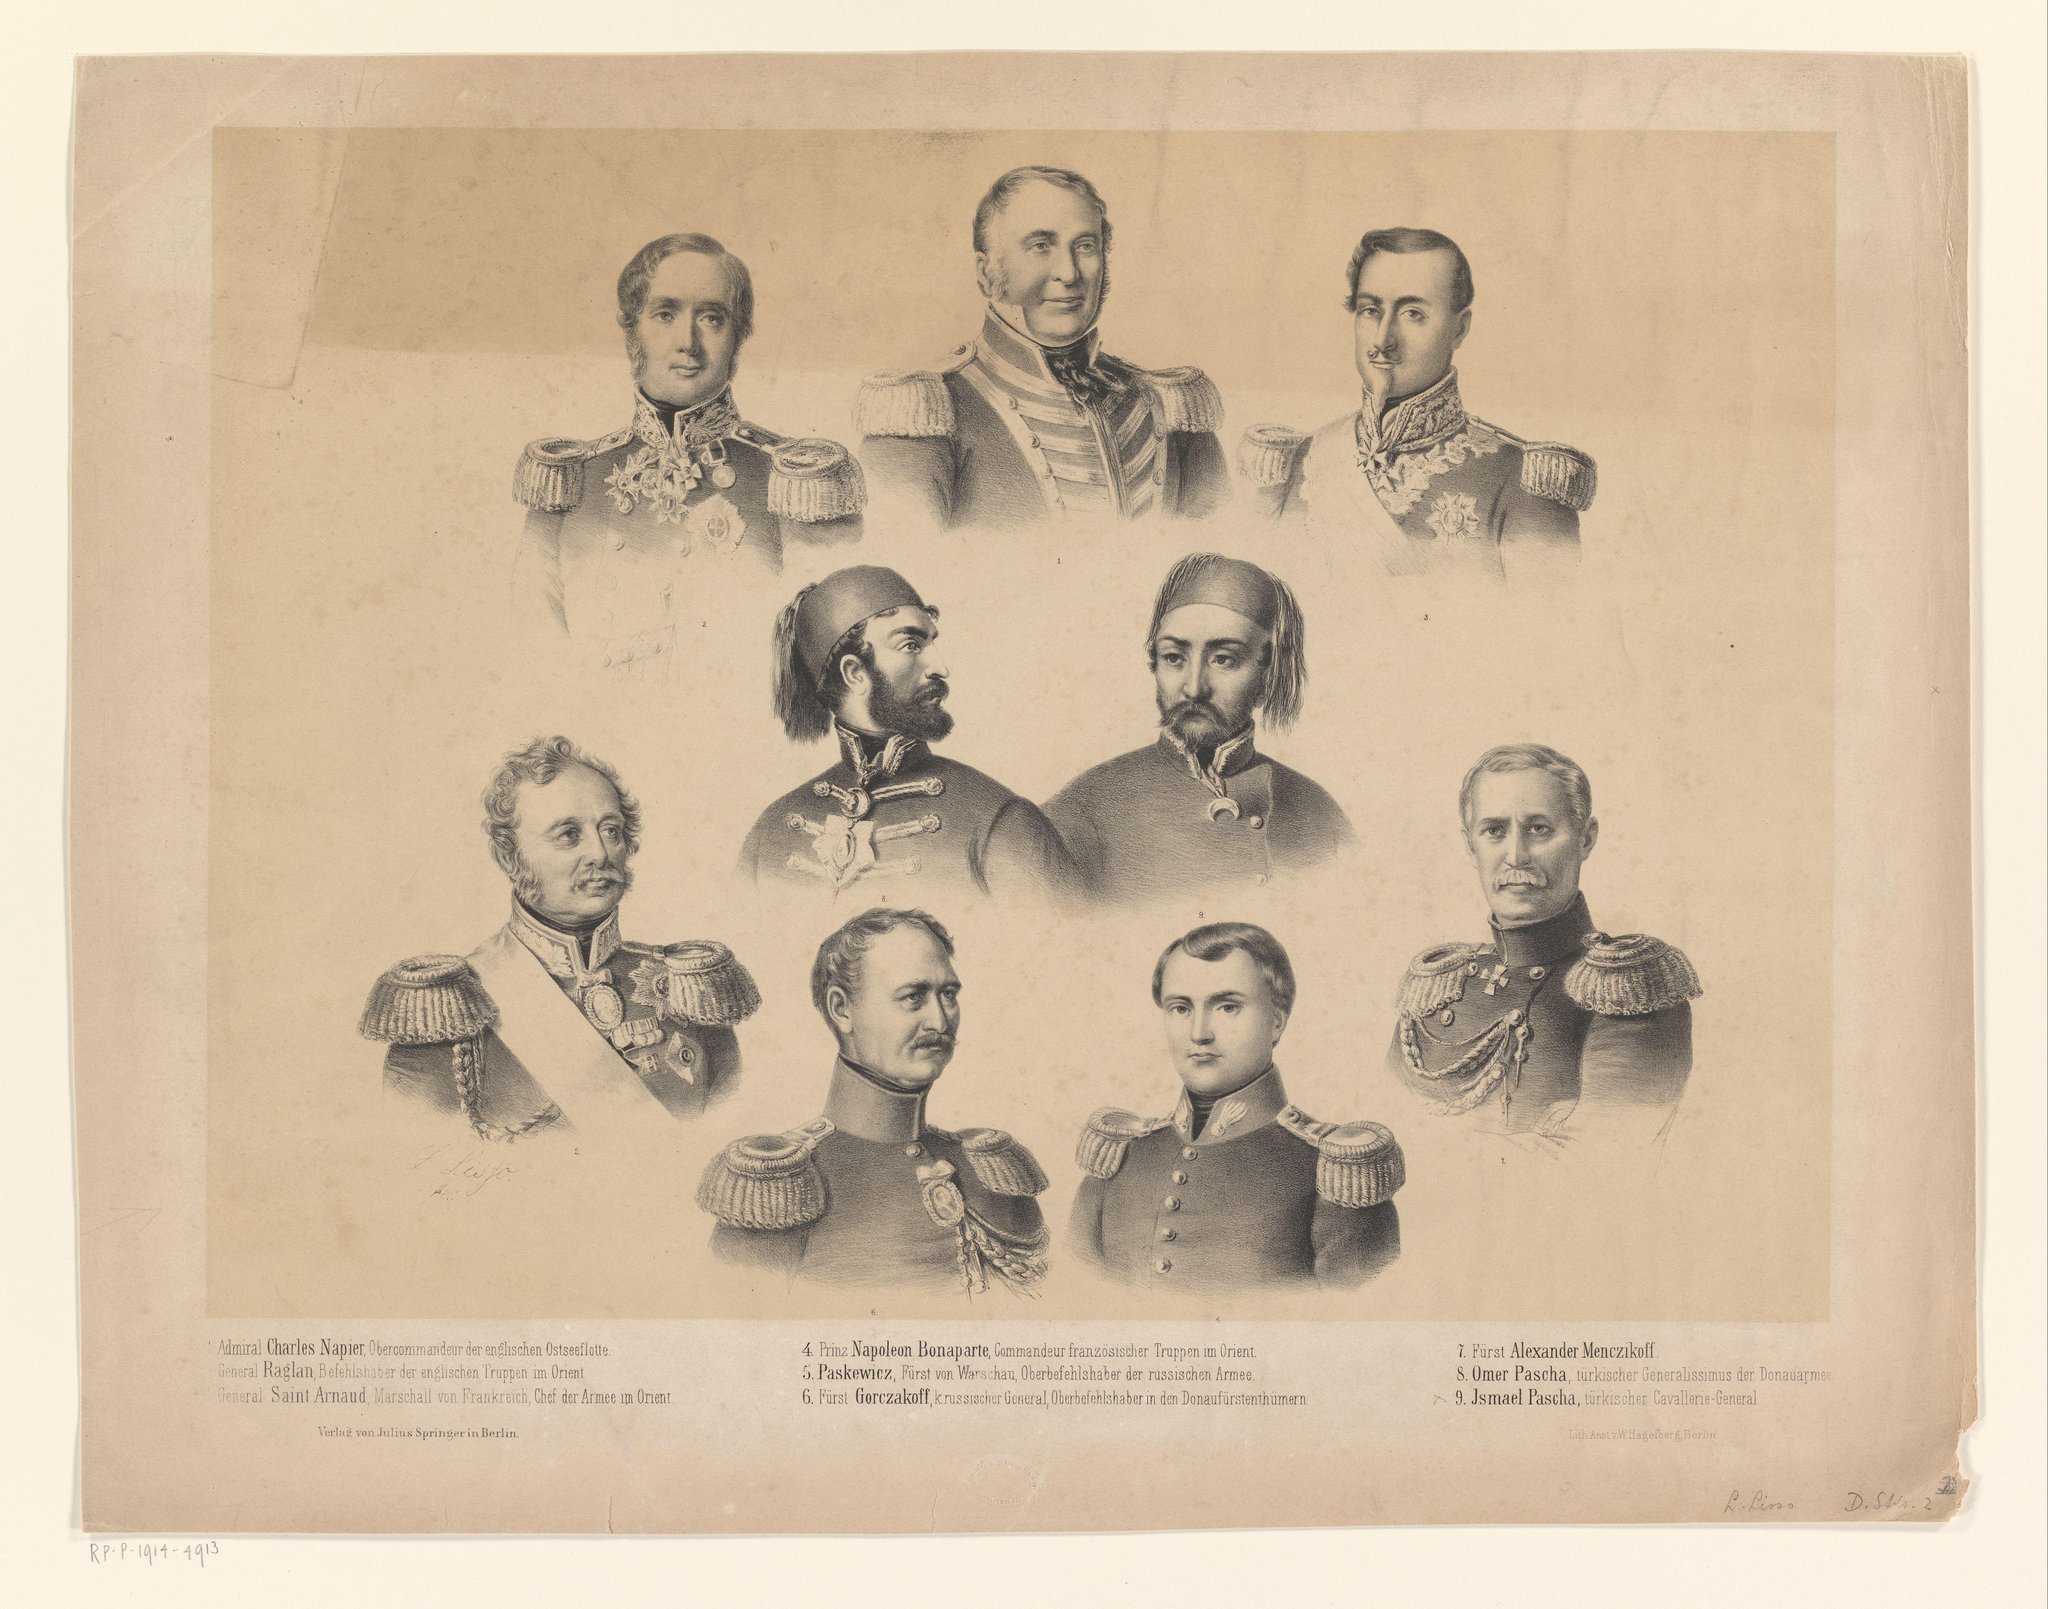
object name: print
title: Portretten van negen generaals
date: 1820-1860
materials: paper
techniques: tone lithography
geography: berlin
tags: naval officer, earl, mikhail dmitrievich gorchakov, politician, napoleon i (emperor of the french), commander-in-chief, general, marshal, adult man, historical persons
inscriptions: collector's mark: Lugt 2228, check stamp: ‘Julius Springer Berlin’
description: Portretten van Charles John Napier, FitzRoy Somerset (baron van Raglan), Jacques Leroy de Saint-Arnaud, Napoleon Bonaparte, Ivan Paskevitsj, Mikhail Dmitrievich Gorchakov, Alexander Sergeyevich Menshikov, Omar Pascha en Ismael Pascha.